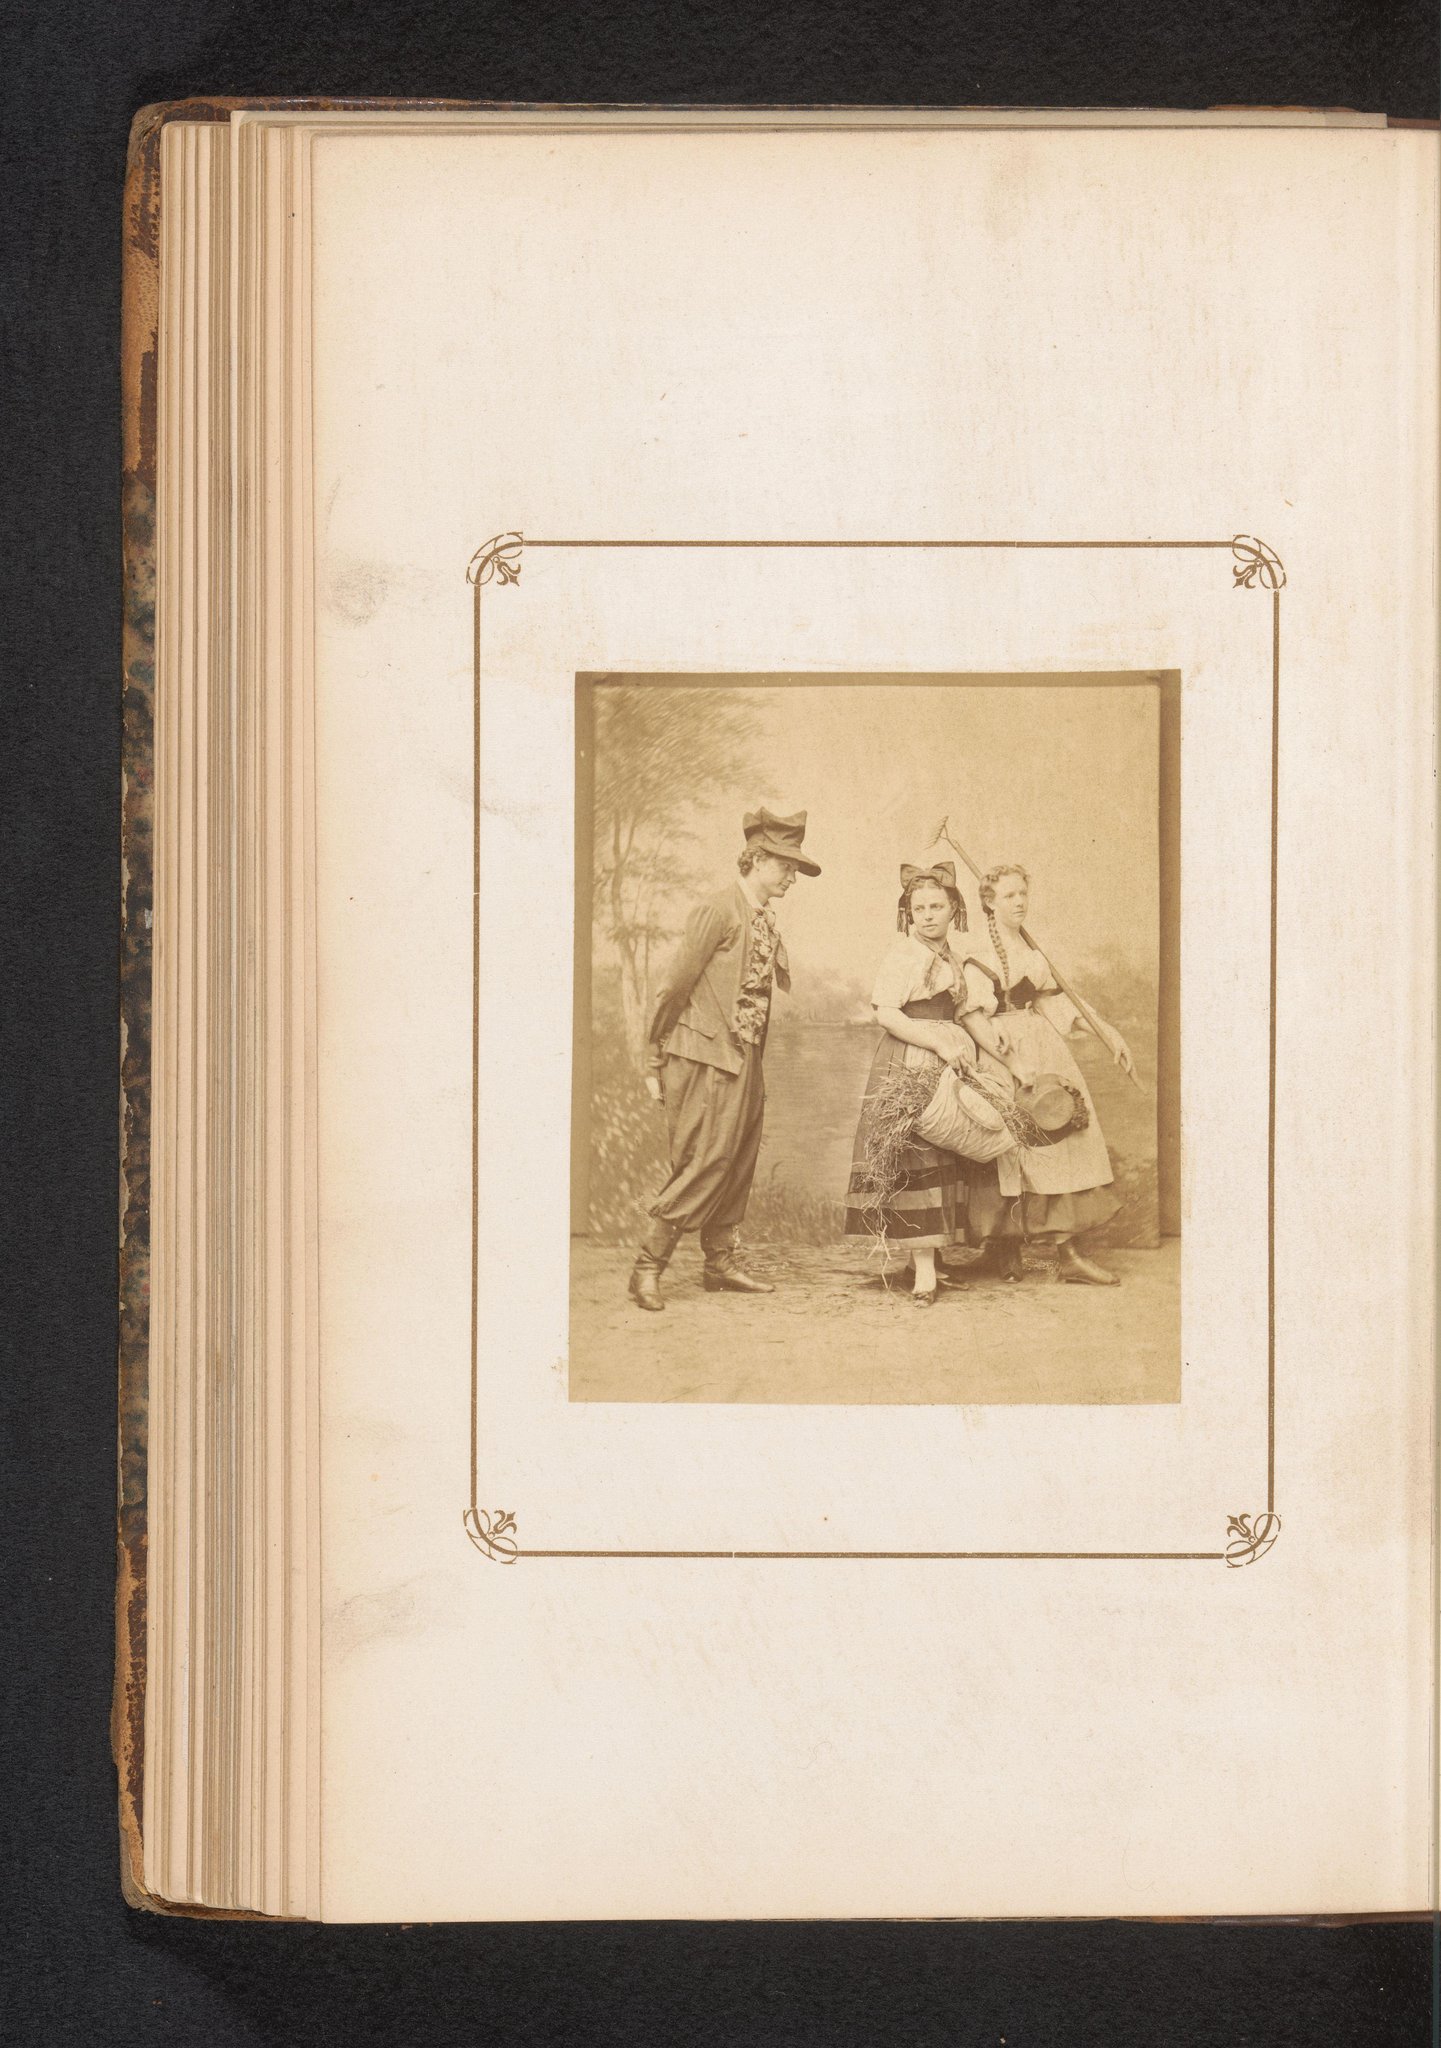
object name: photograph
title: Portret van een onbekende jonge man en twee onbekende jonge vrouwen, voor een achtergrond met een landschap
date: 1861-1866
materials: photographic support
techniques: albumen print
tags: adolescent, young woman, maiden, youth, adolescent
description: Foto tegenover pagina 193, achter semi-transparante omslag.